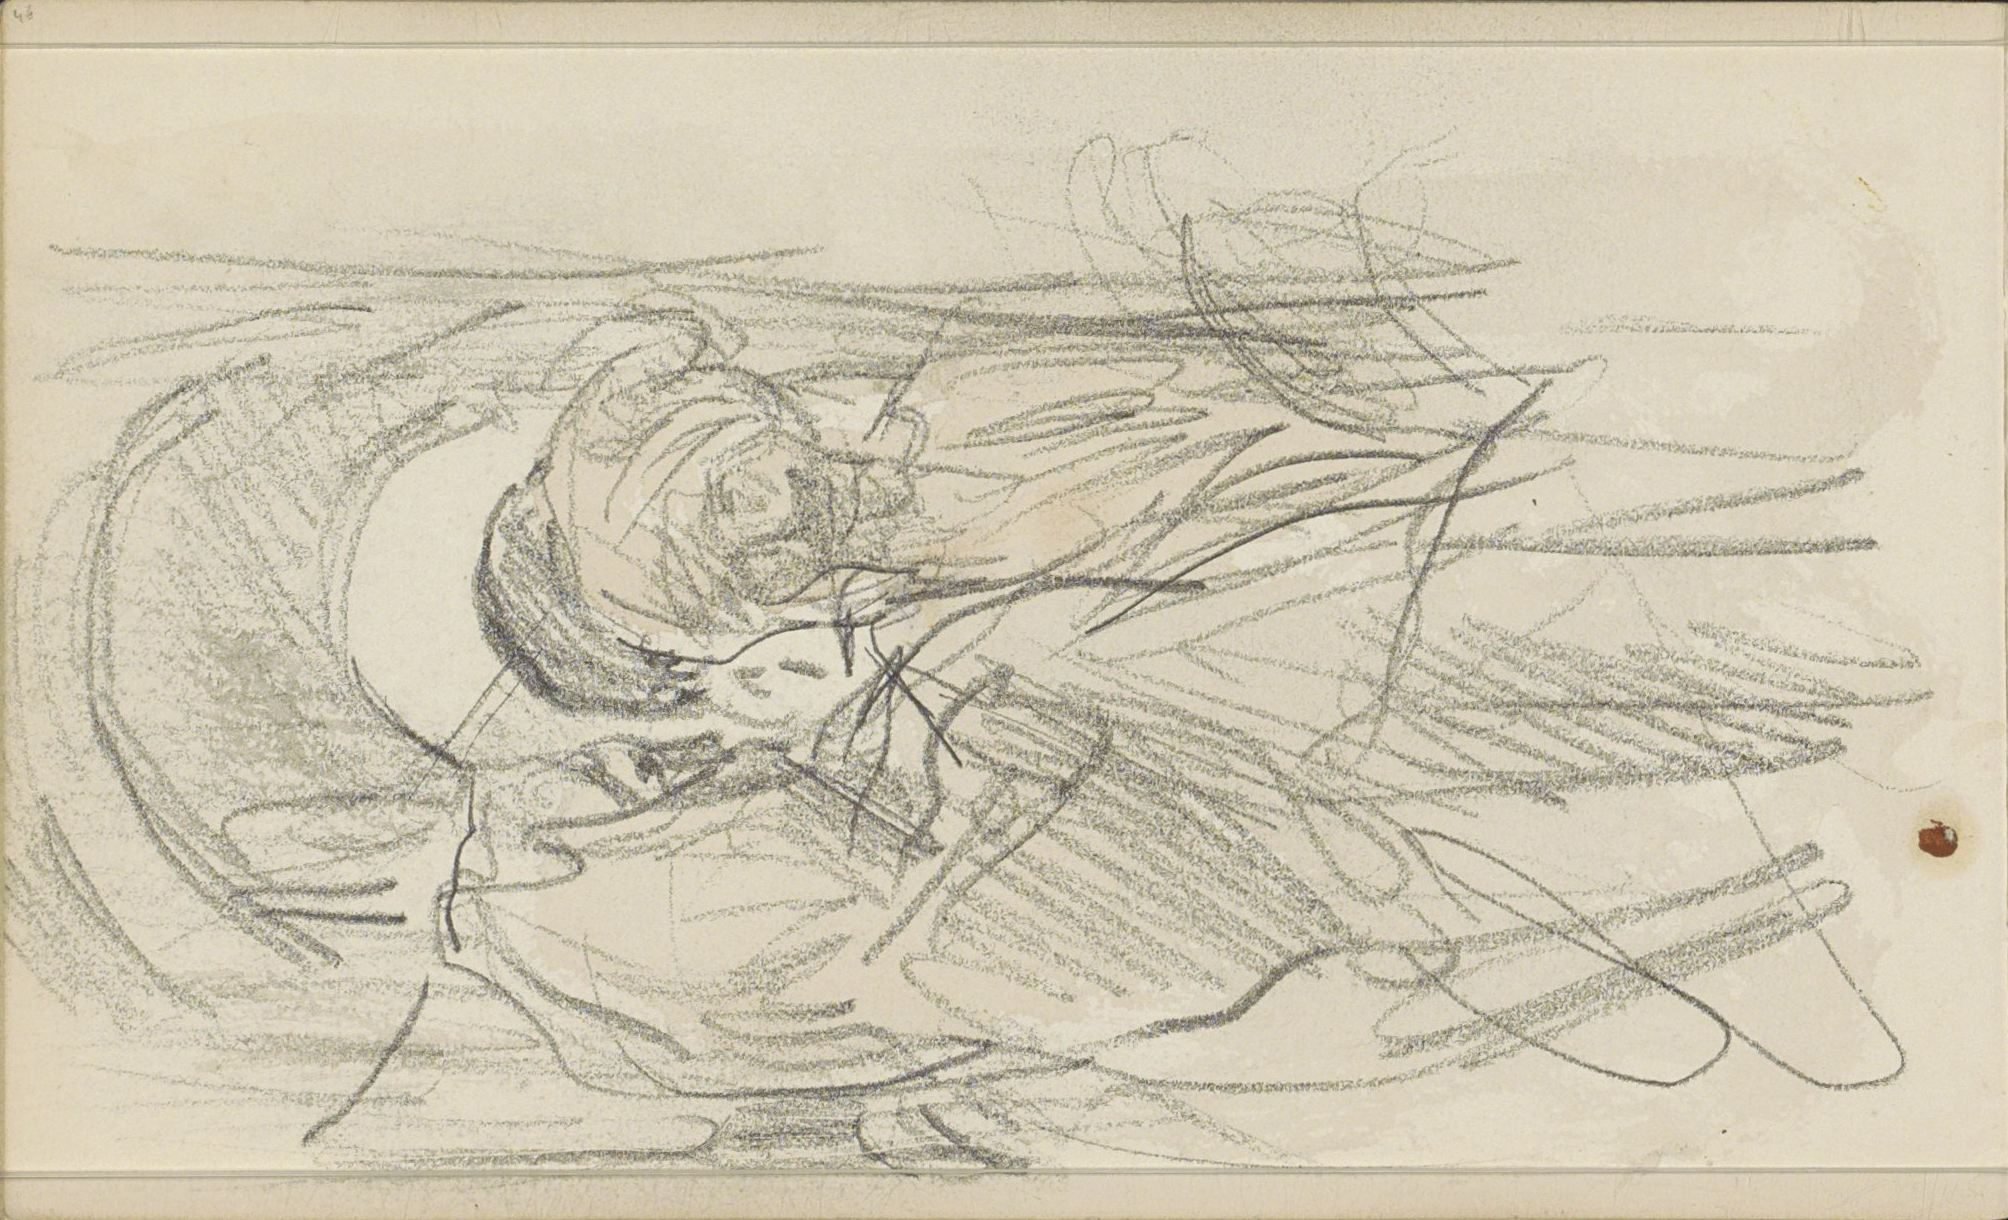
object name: sketchbook leaf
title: Twee Algerijnen voor een poort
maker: marius bauer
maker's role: draughtsman, print maker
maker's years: 1867-1932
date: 1922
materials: paper, pencil, watercolor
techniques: brush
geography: algeria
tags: africans, adult man, arch, archivolt ~ architecture, folk costume, regional costume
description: De mannen staan naar elkaar toe gedraaid en dragen traditioneel Noord-Afrikaans kostuum. Pagina 46 uit een schetsboek met 31 bladen.